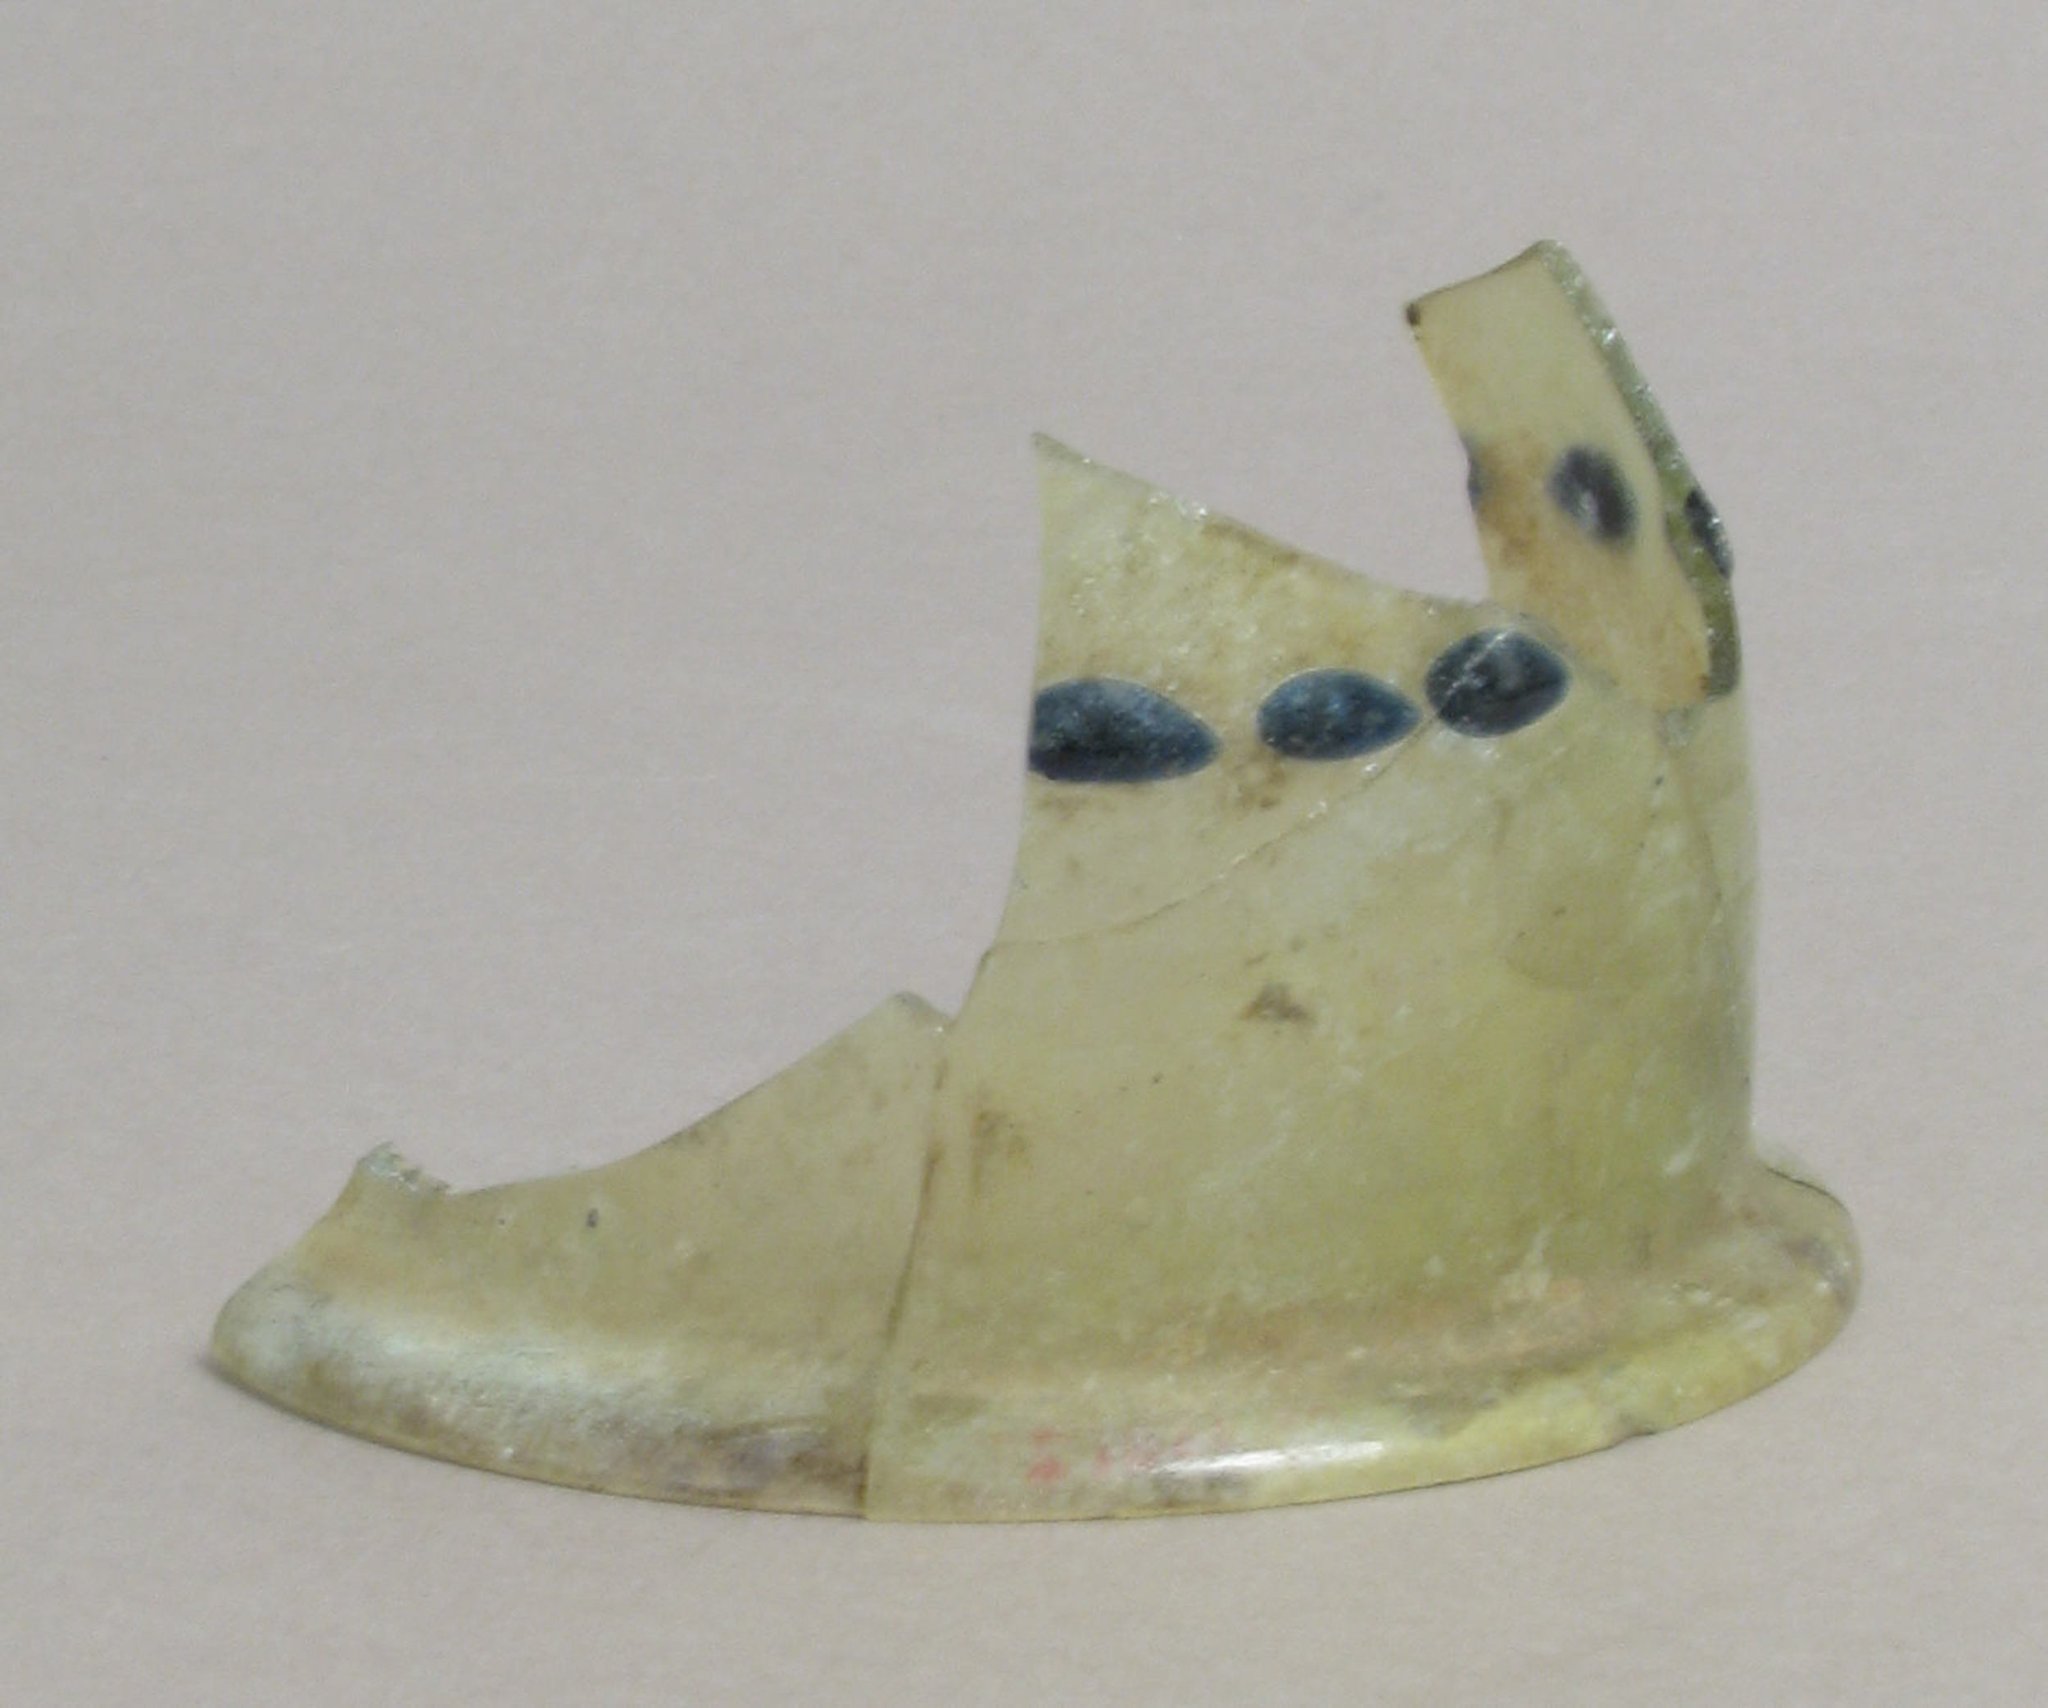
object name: fragment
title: Lip of a Vessel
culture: coptic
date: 301-433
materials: glass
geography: egypt